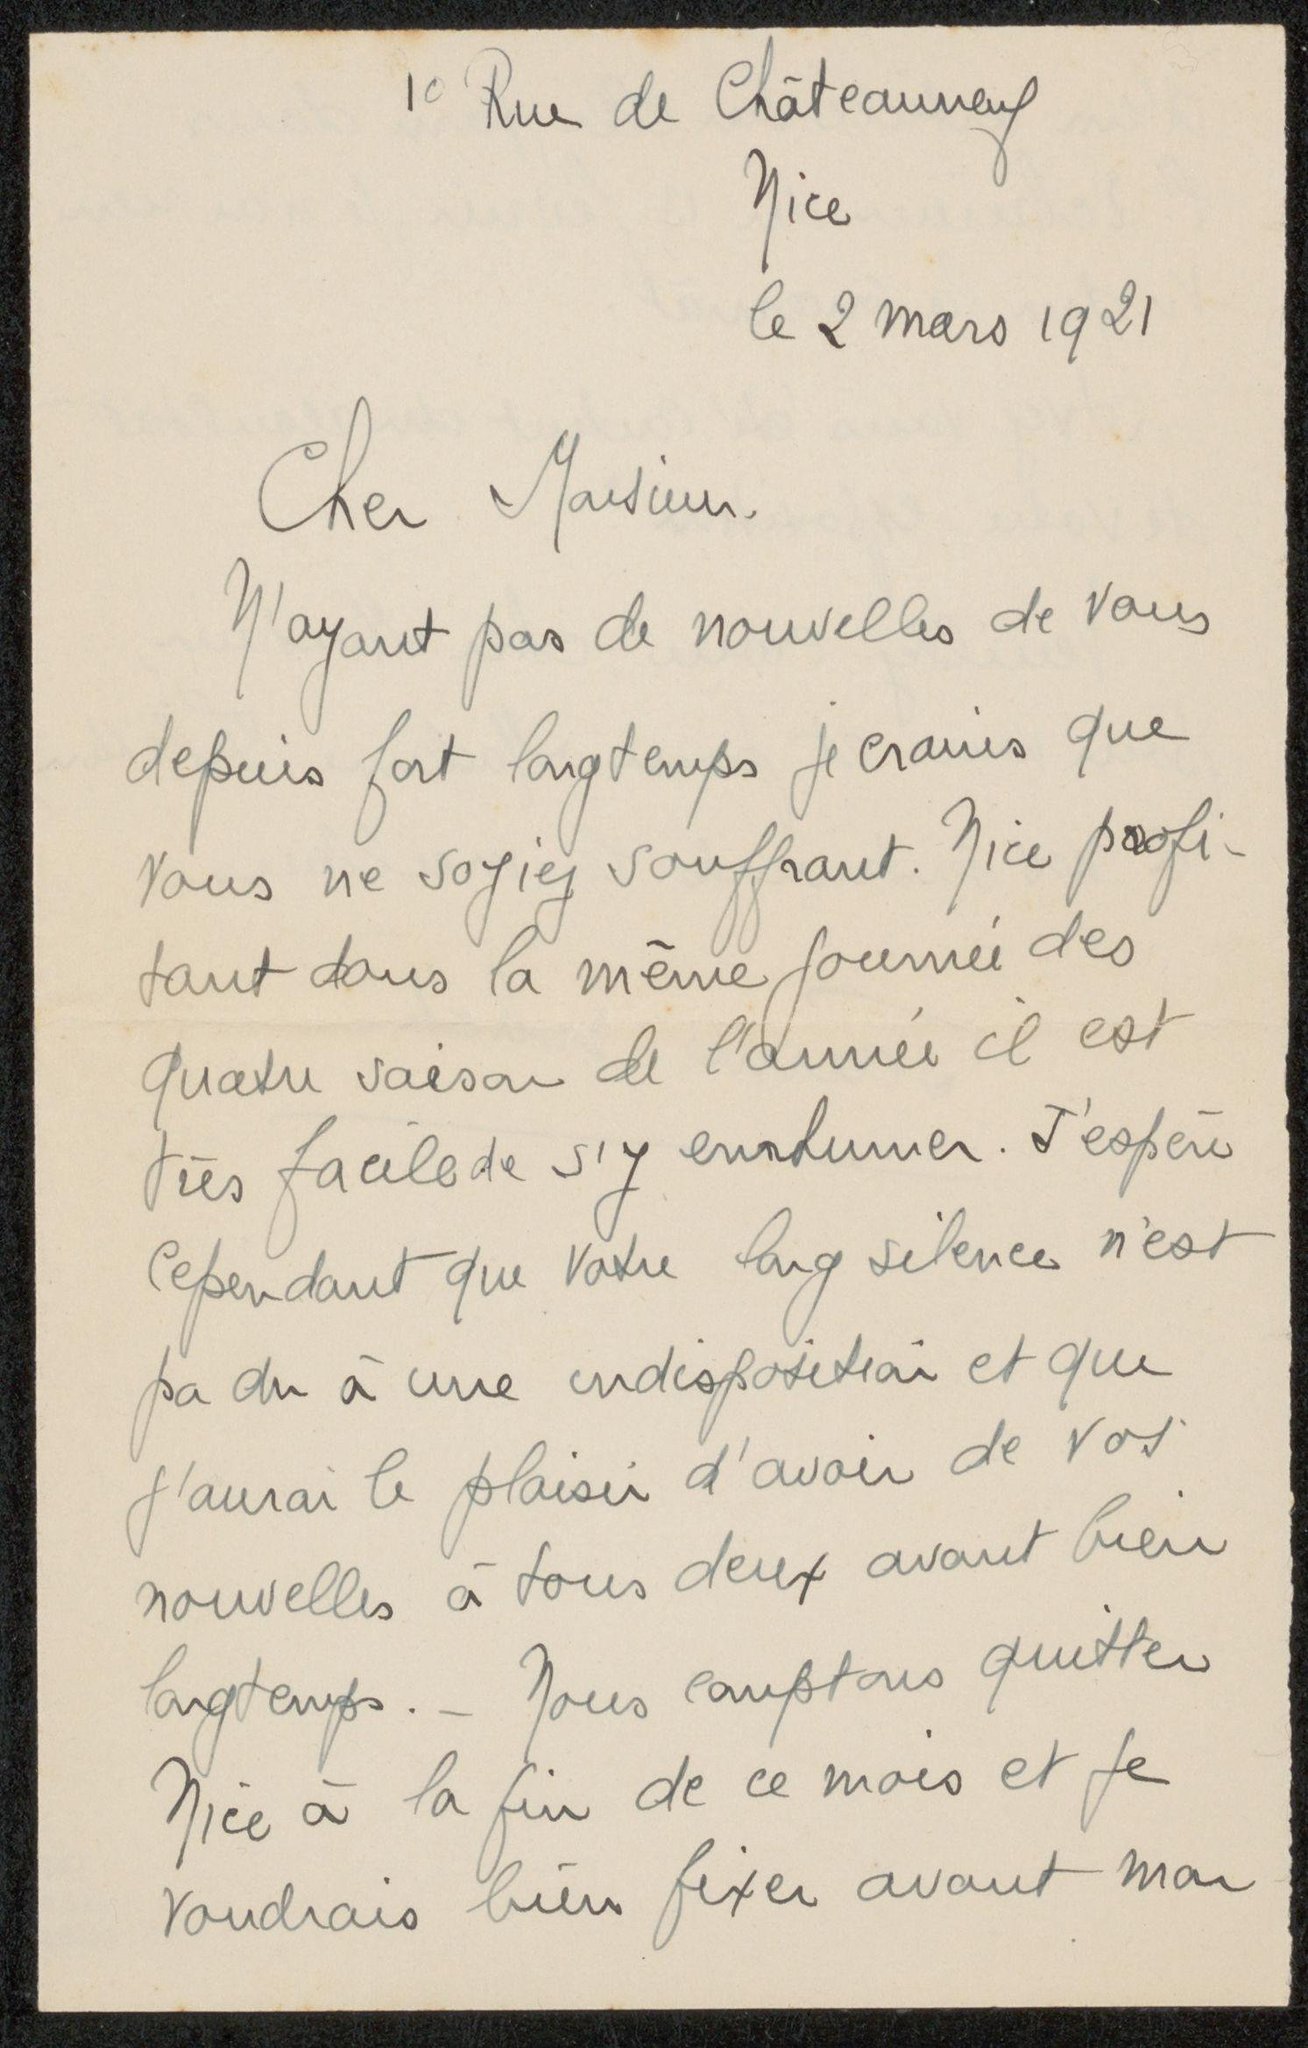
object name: letter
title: Brief aan Philip Zilcken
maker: jeanne erlich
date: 1921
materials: ink, paper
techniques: pen, writing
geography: nice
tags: the hague, painter, draughtsman, philip zilcken, literature ~ arts, temporary exhibition, 'salon'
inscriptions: collector's mark: ‘RPK’